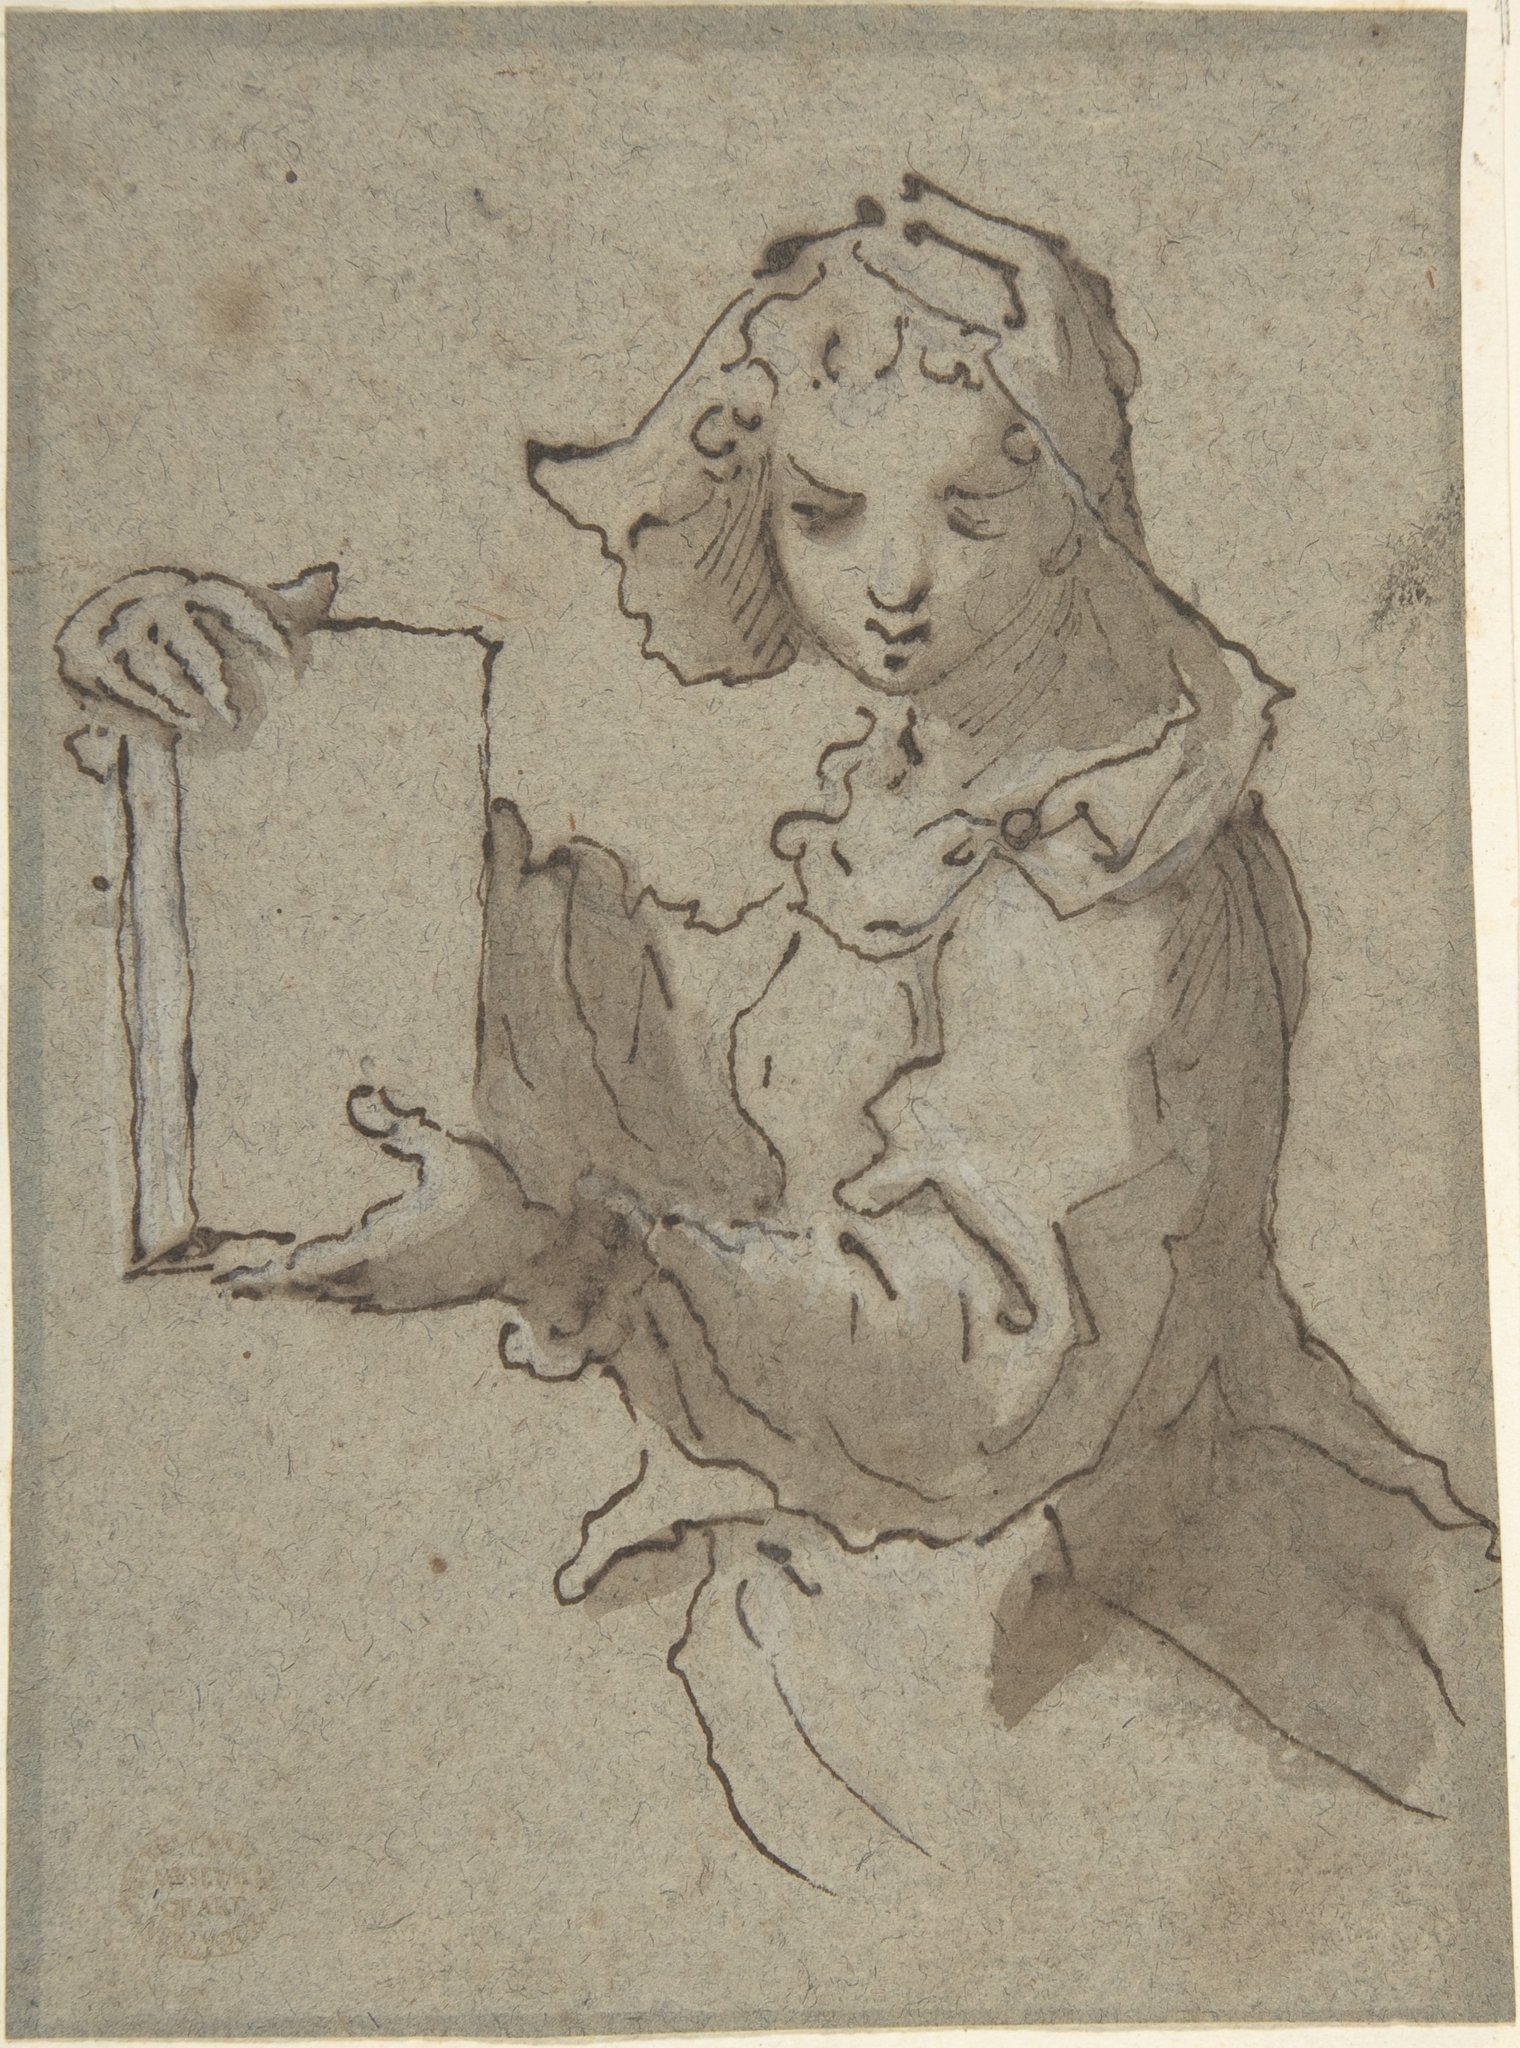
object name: drawing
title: Girl with Book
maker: anonymous, italian, bolognese, 18th century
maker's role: artist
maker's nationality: italian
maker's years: 1700-1800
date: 1701-1800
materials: ink, paper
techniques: pen, wash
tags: books,girls